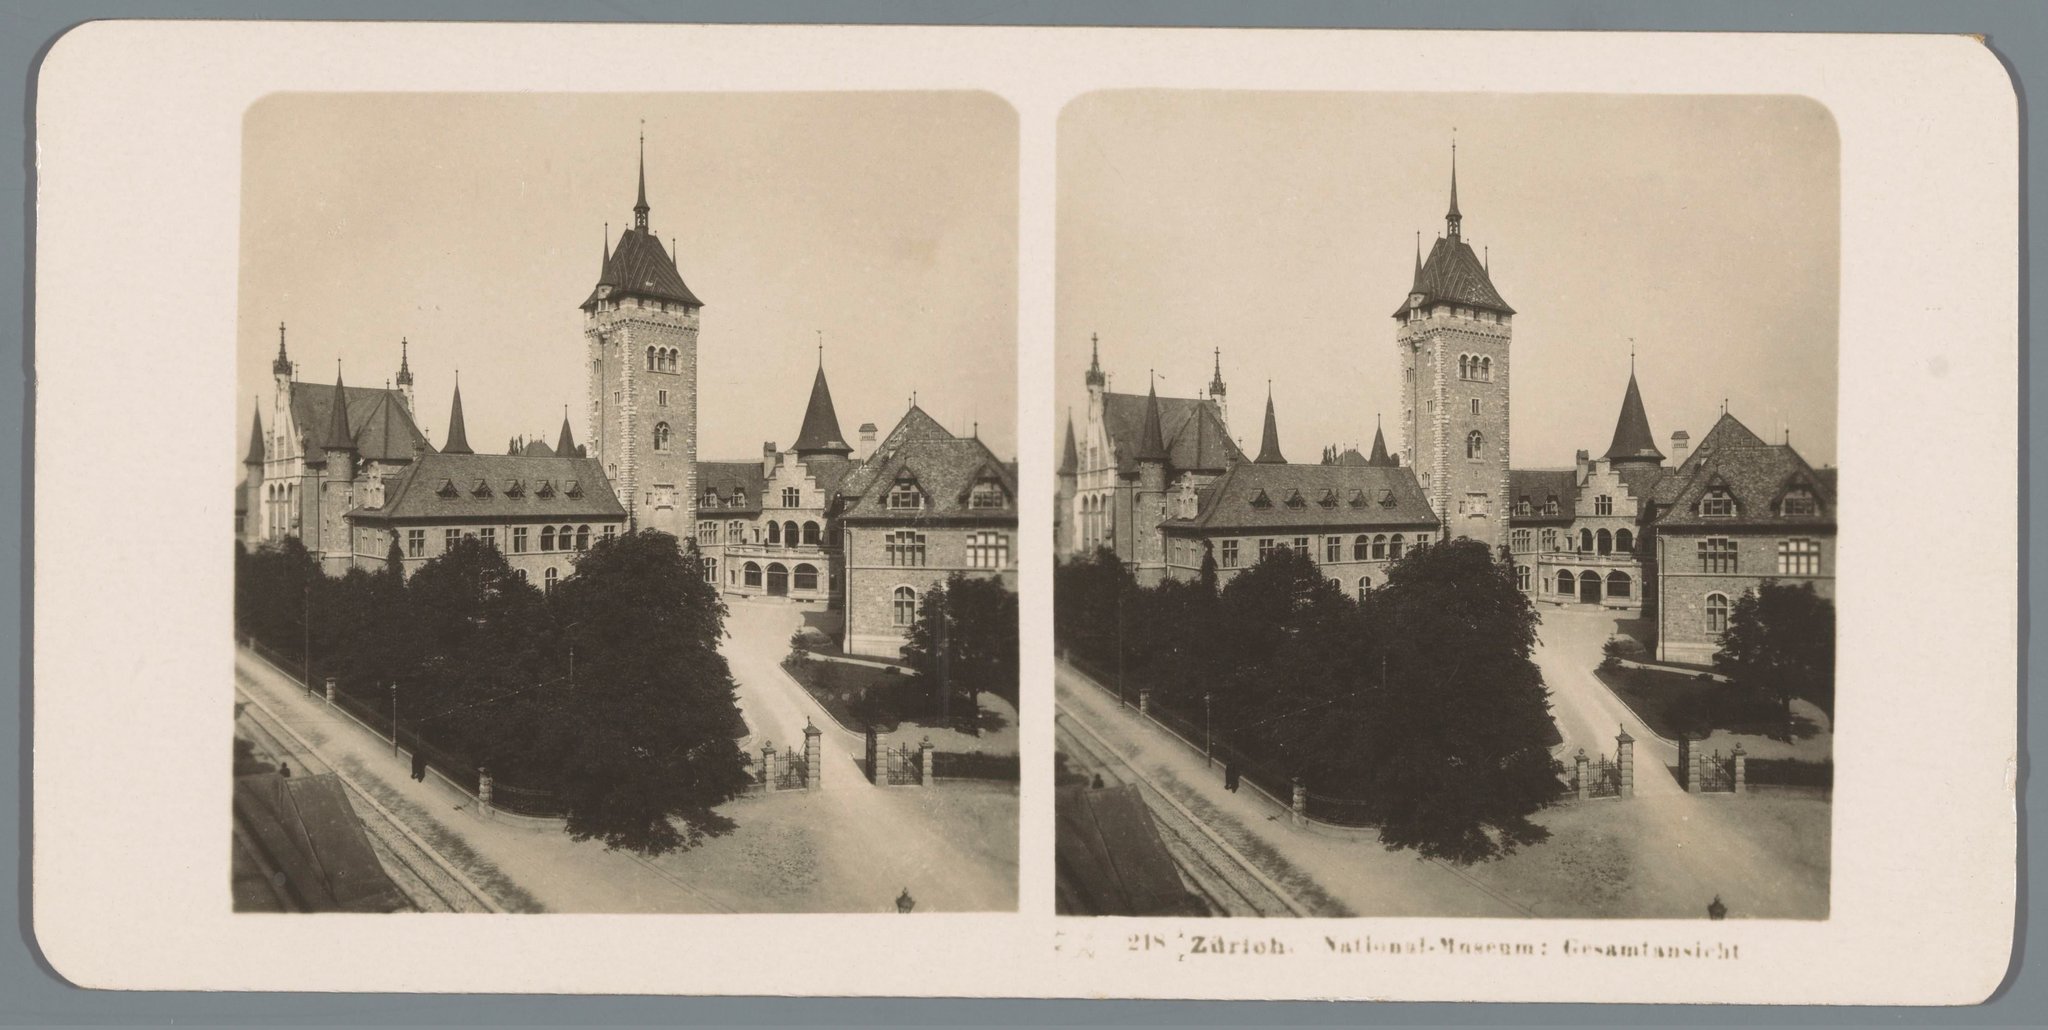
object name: stereograph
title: Zürich. National-Museum: Gesamtansicht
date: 1906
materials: cardboard, photographic support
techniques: gelatin silver print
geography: zurich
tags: permanent exhibition, museum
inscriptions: inscription: ‘Neue Photographische Gesellschaft A. G., Steglitz-Berlin 1906.’, number: ‘218’